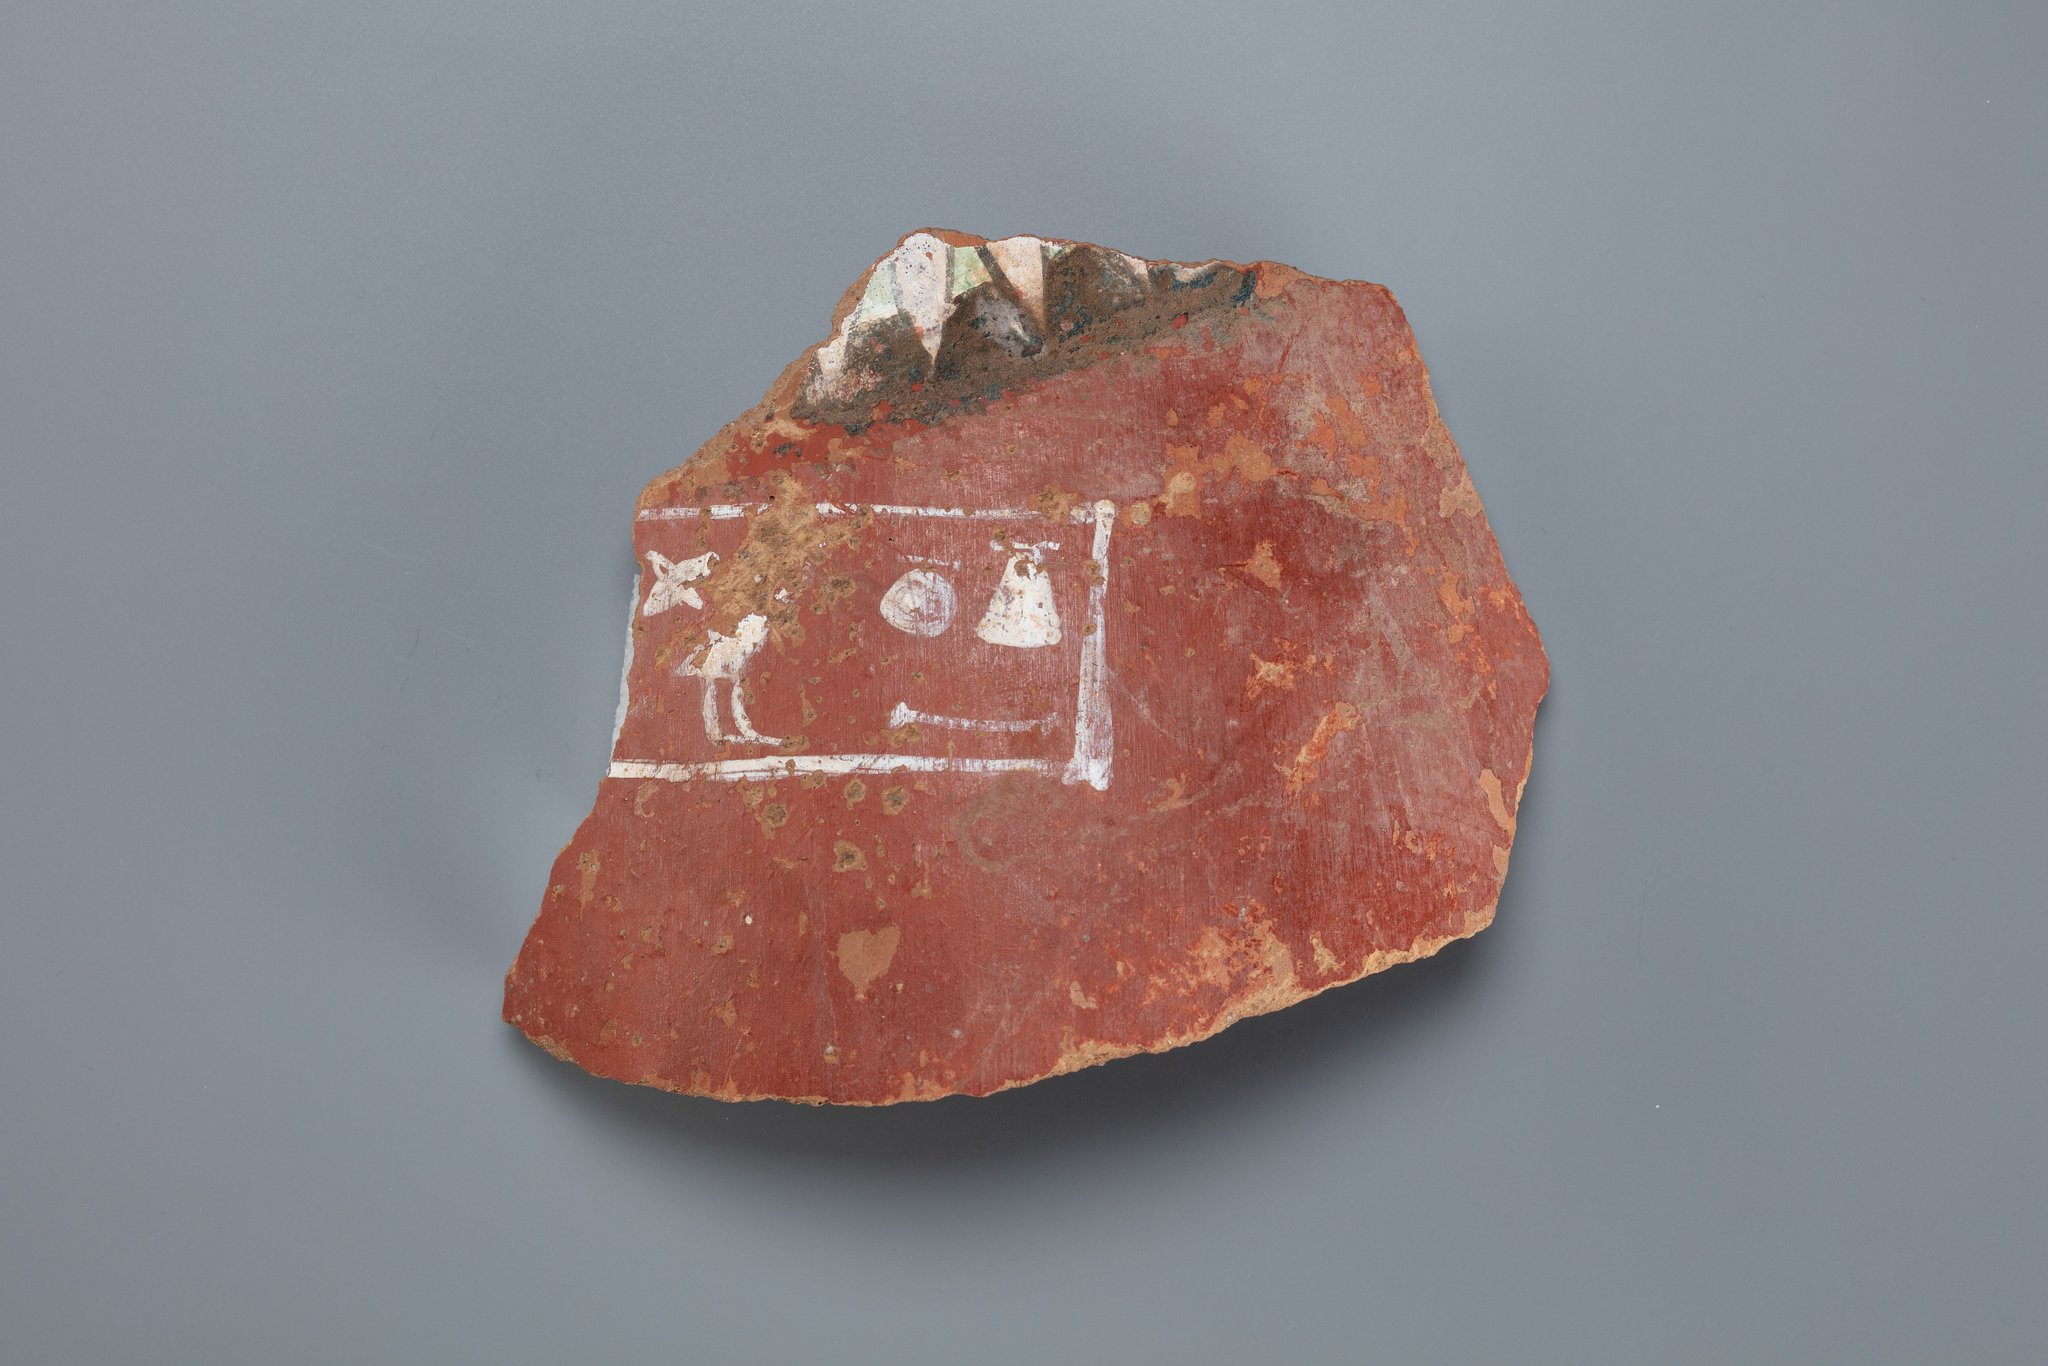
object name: jar label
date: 1390-1352 BCE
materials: ink, paint, pottery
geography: egypt